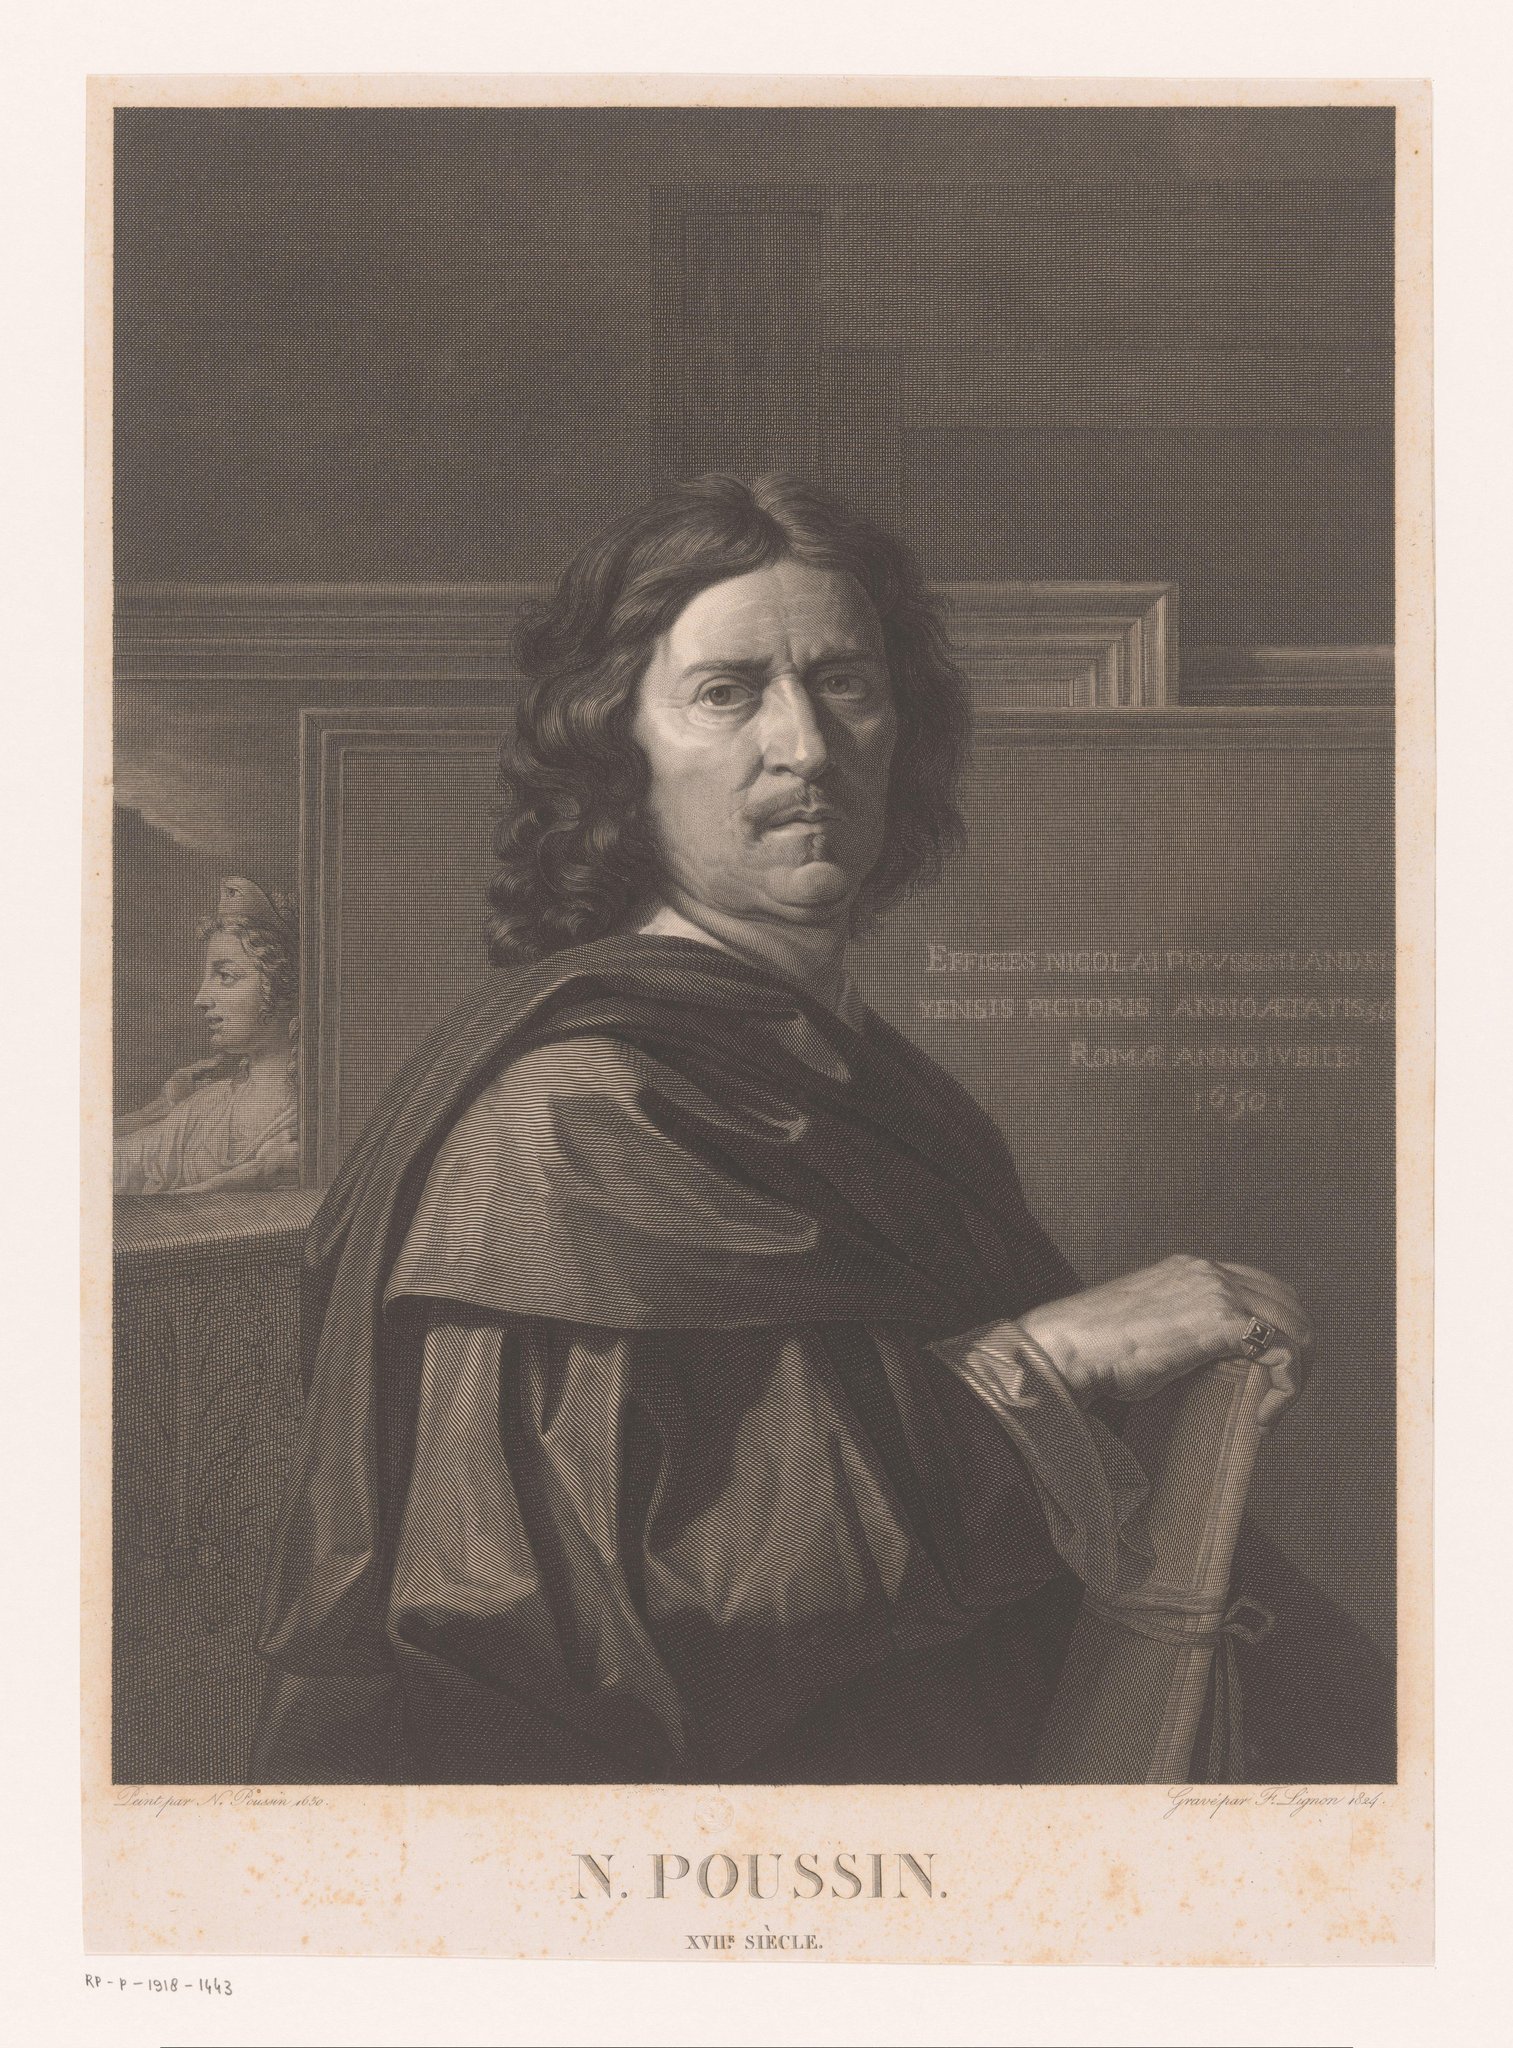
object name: print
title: Portret van Nicolas Poussin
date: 1824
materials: paper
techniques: engraving, etching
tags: painter, draughtsman, nicolas poussin, historical persons, portrait, self-portrait of artist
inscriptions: collector's mark: Lugt 2233, check stamp: Lugt 2581